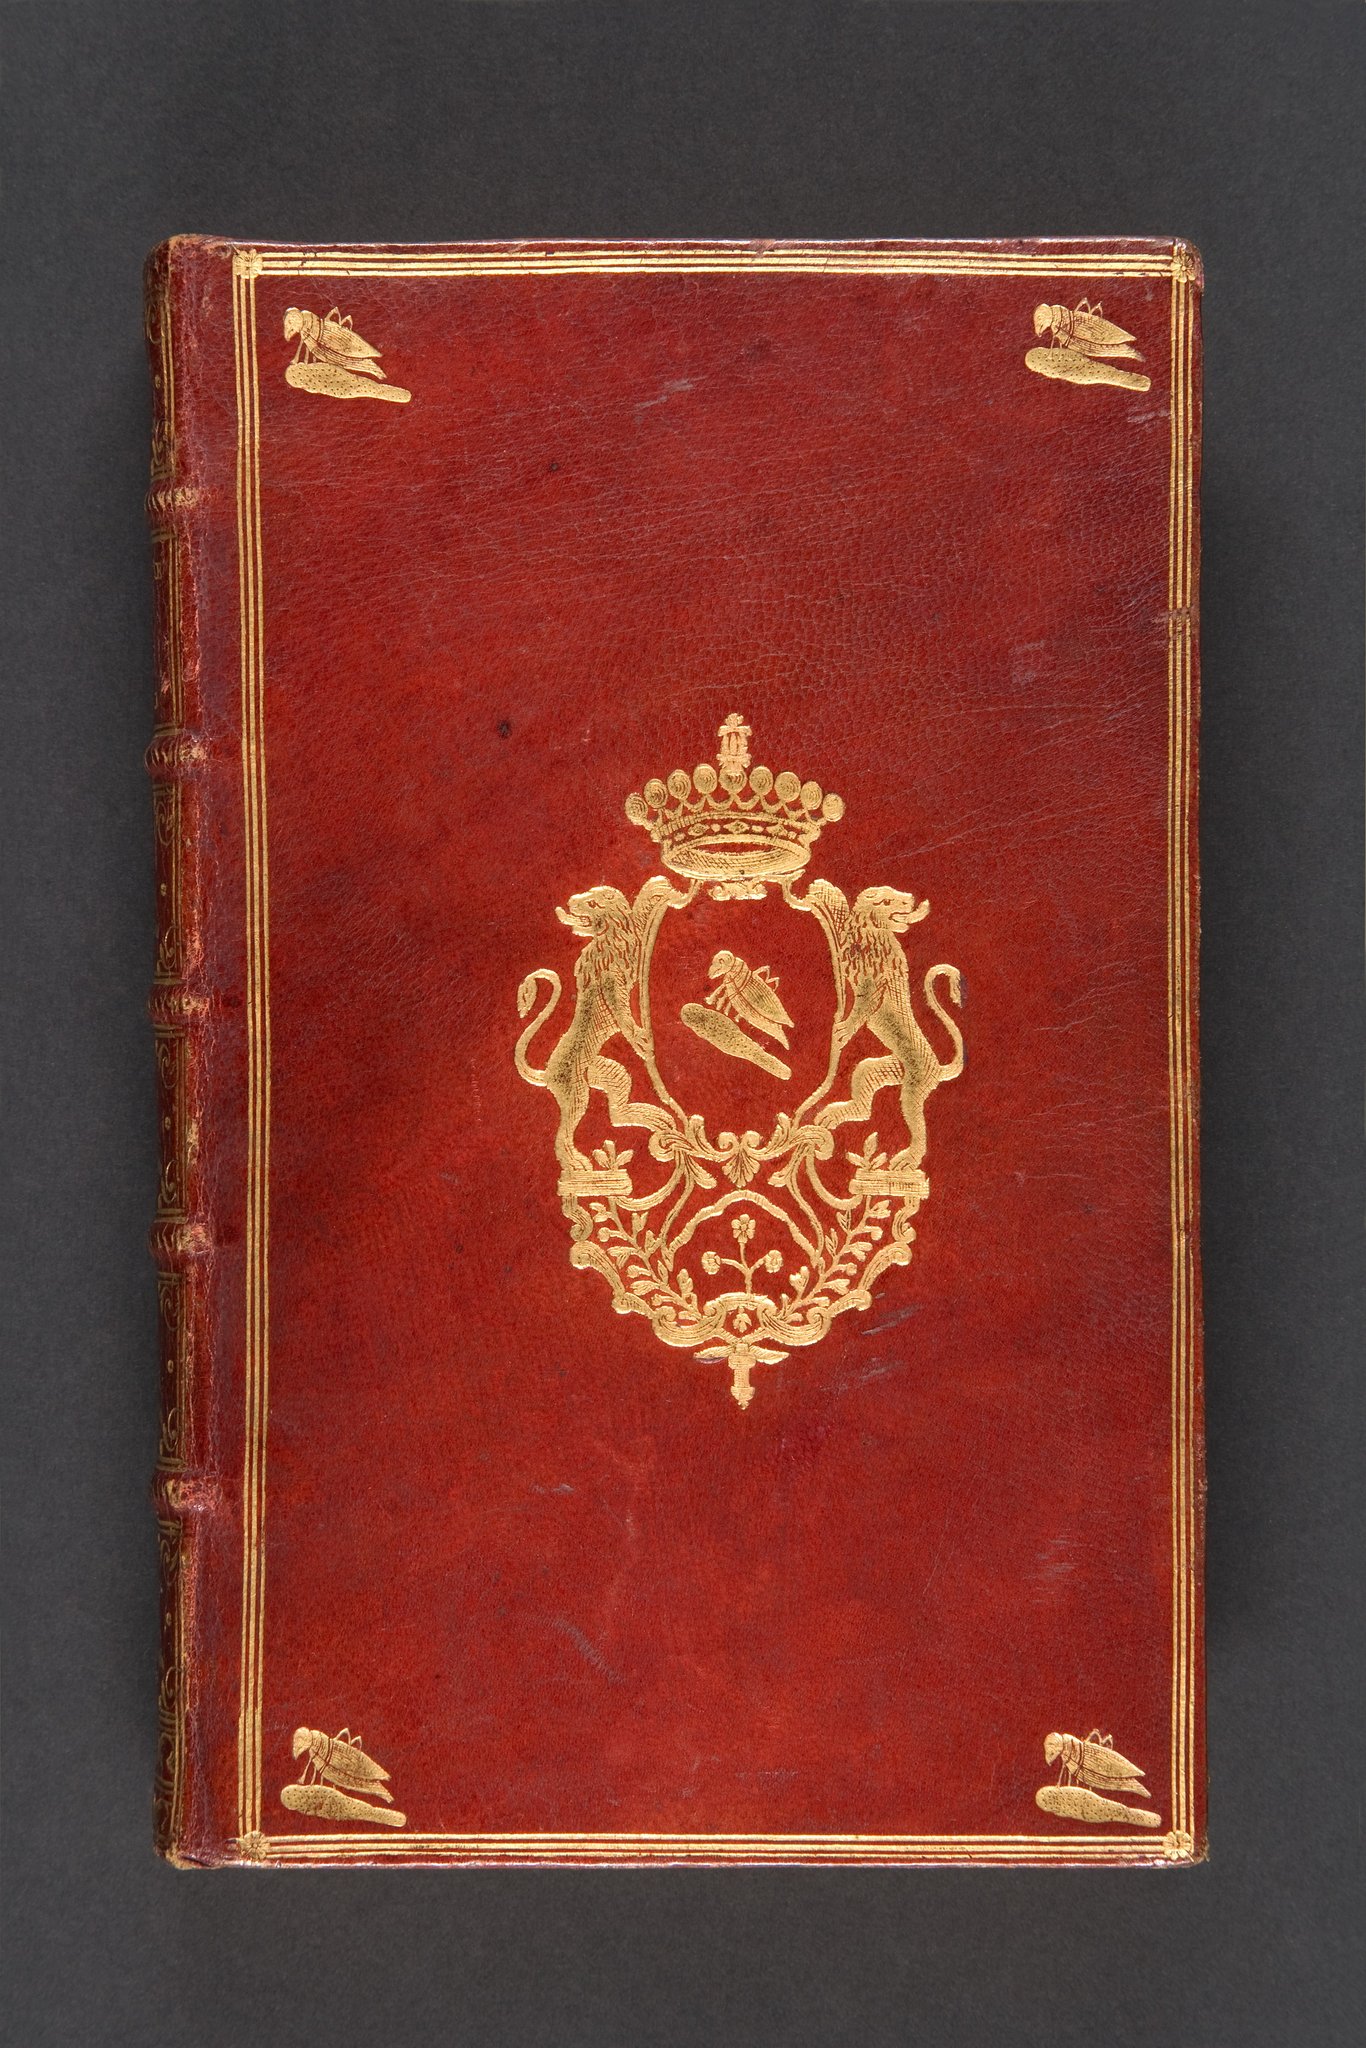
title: Loffice de Noël, 1768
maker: catholic church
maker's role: author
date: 1768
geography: france